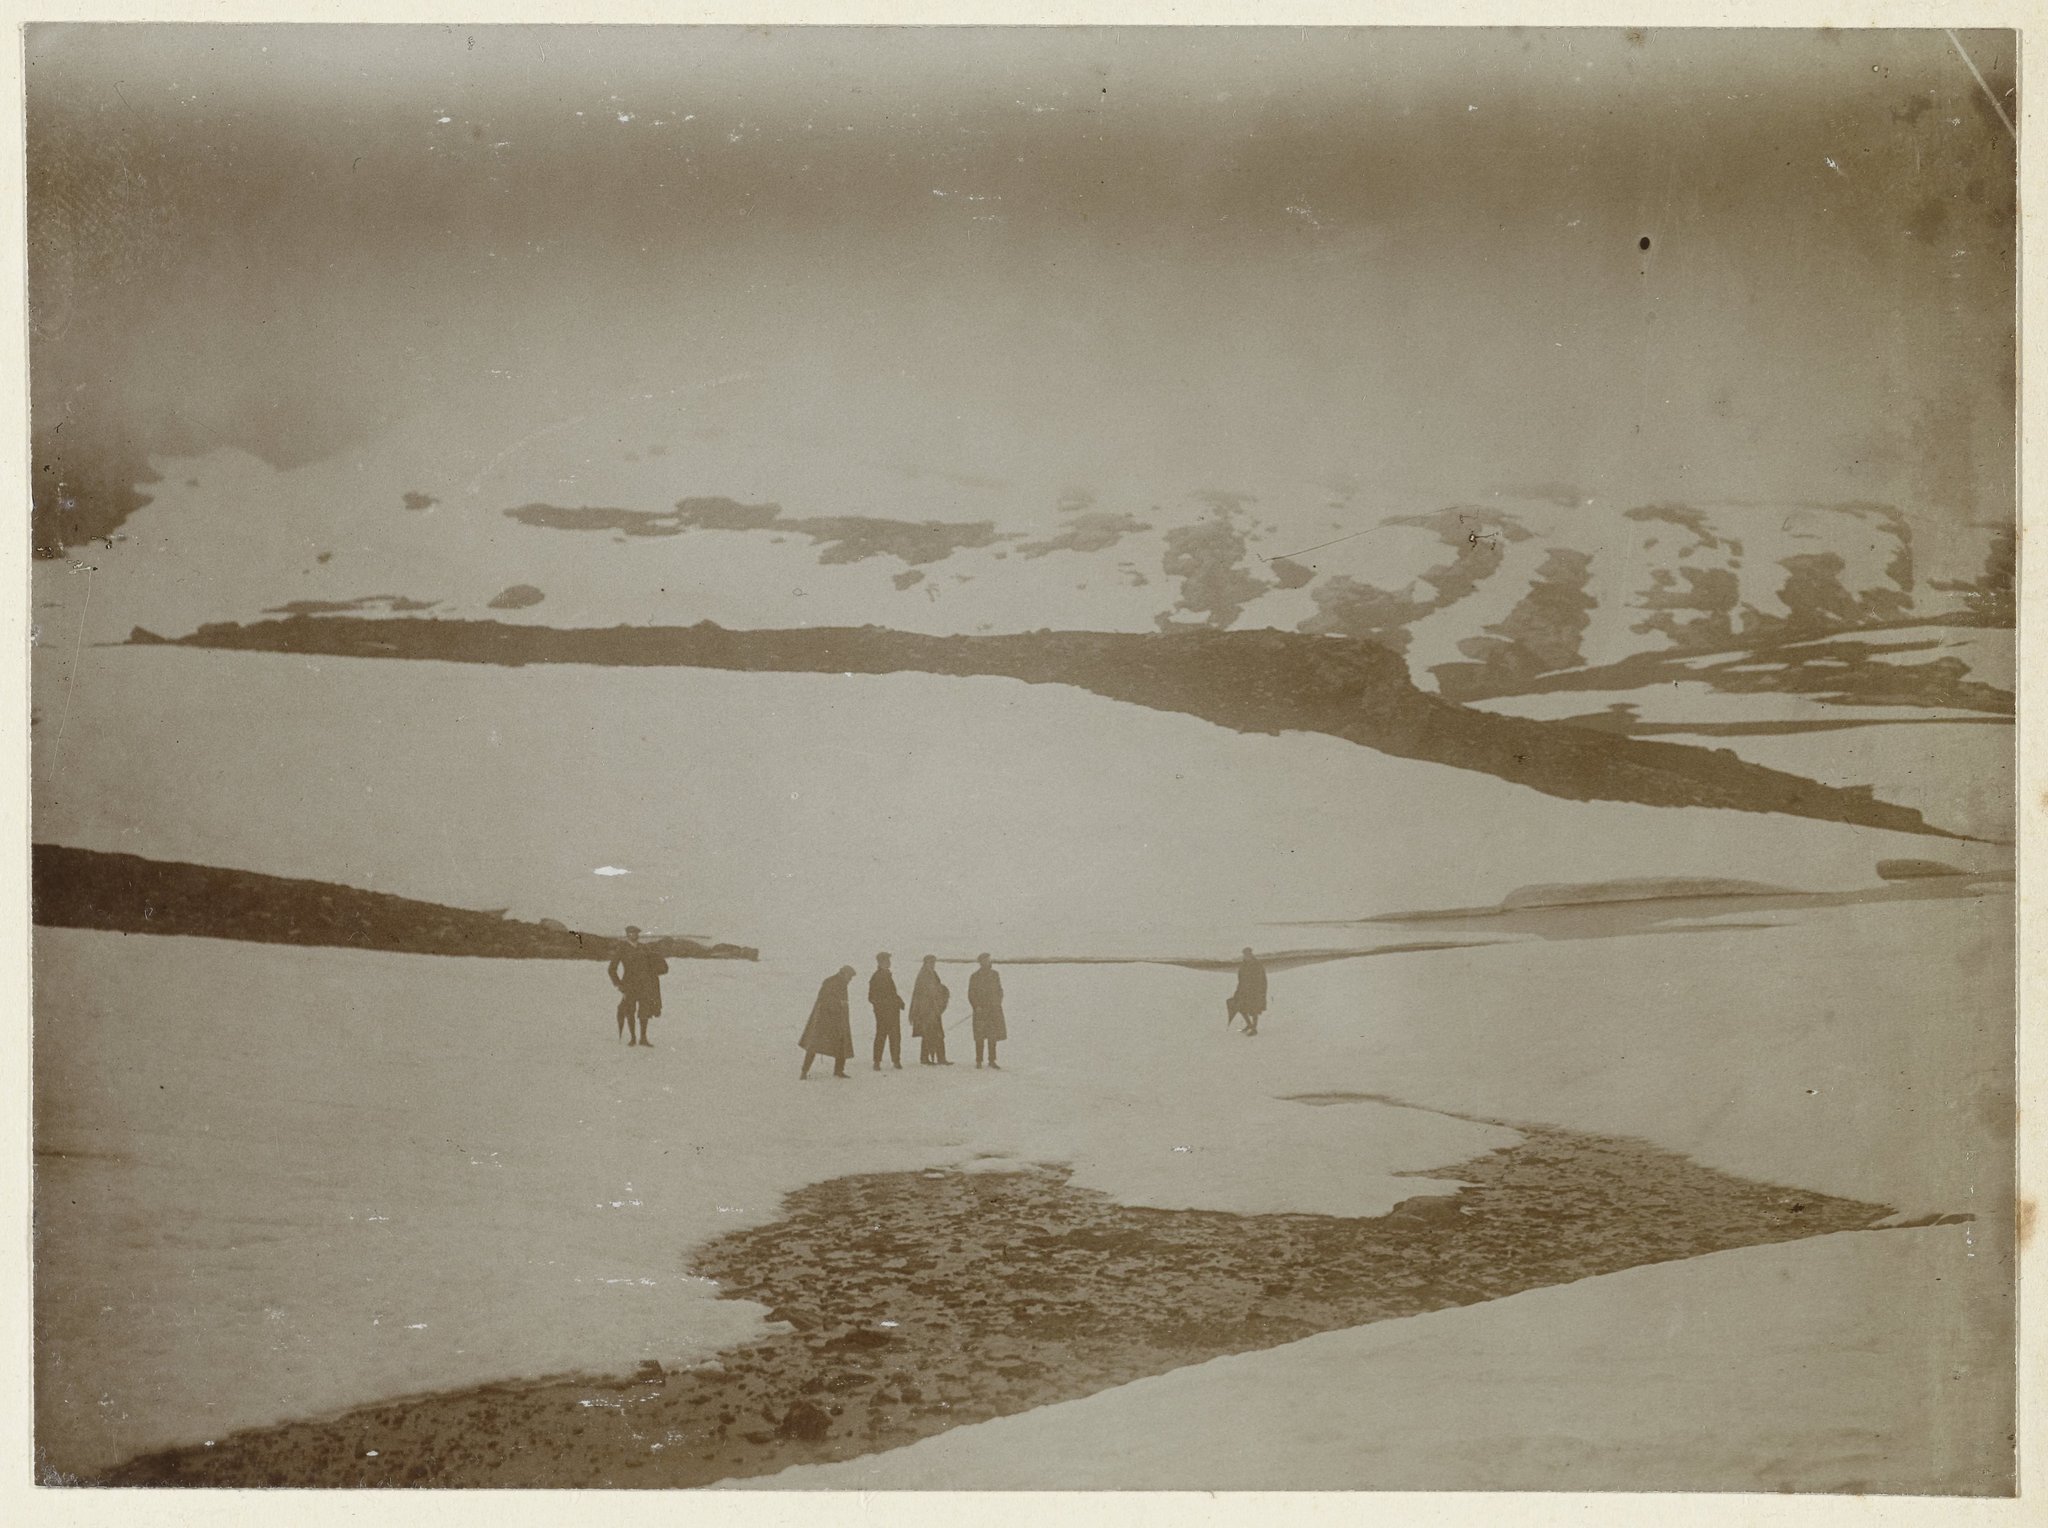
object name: photograph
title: Tijdens een wandeling hoog in de bergen op een gletscher in de Harz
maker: geldolph adriaan kessler (dolph)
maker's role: fotograaf, industrieel, voetballer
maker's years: 1884-1945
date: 1903-1908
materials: cardboard, photographic support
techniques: gelatin silver print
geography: harz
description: Tijdens een wandeling hoog op de berg op een gletscher in vermoedelijk de Harz. Onderdeel van het fotoalbum van Dolph Kessler met opnamen die hij maakte tijdens zijn verblijf in Engeland en op een wereldreis die hij als secretaris van Henri Deterding (directeur Koninklijke Olie) ondernam naar Nederlands-Indië, Japan, China en de Verenigde Staten, tussen 1906 en 1908.